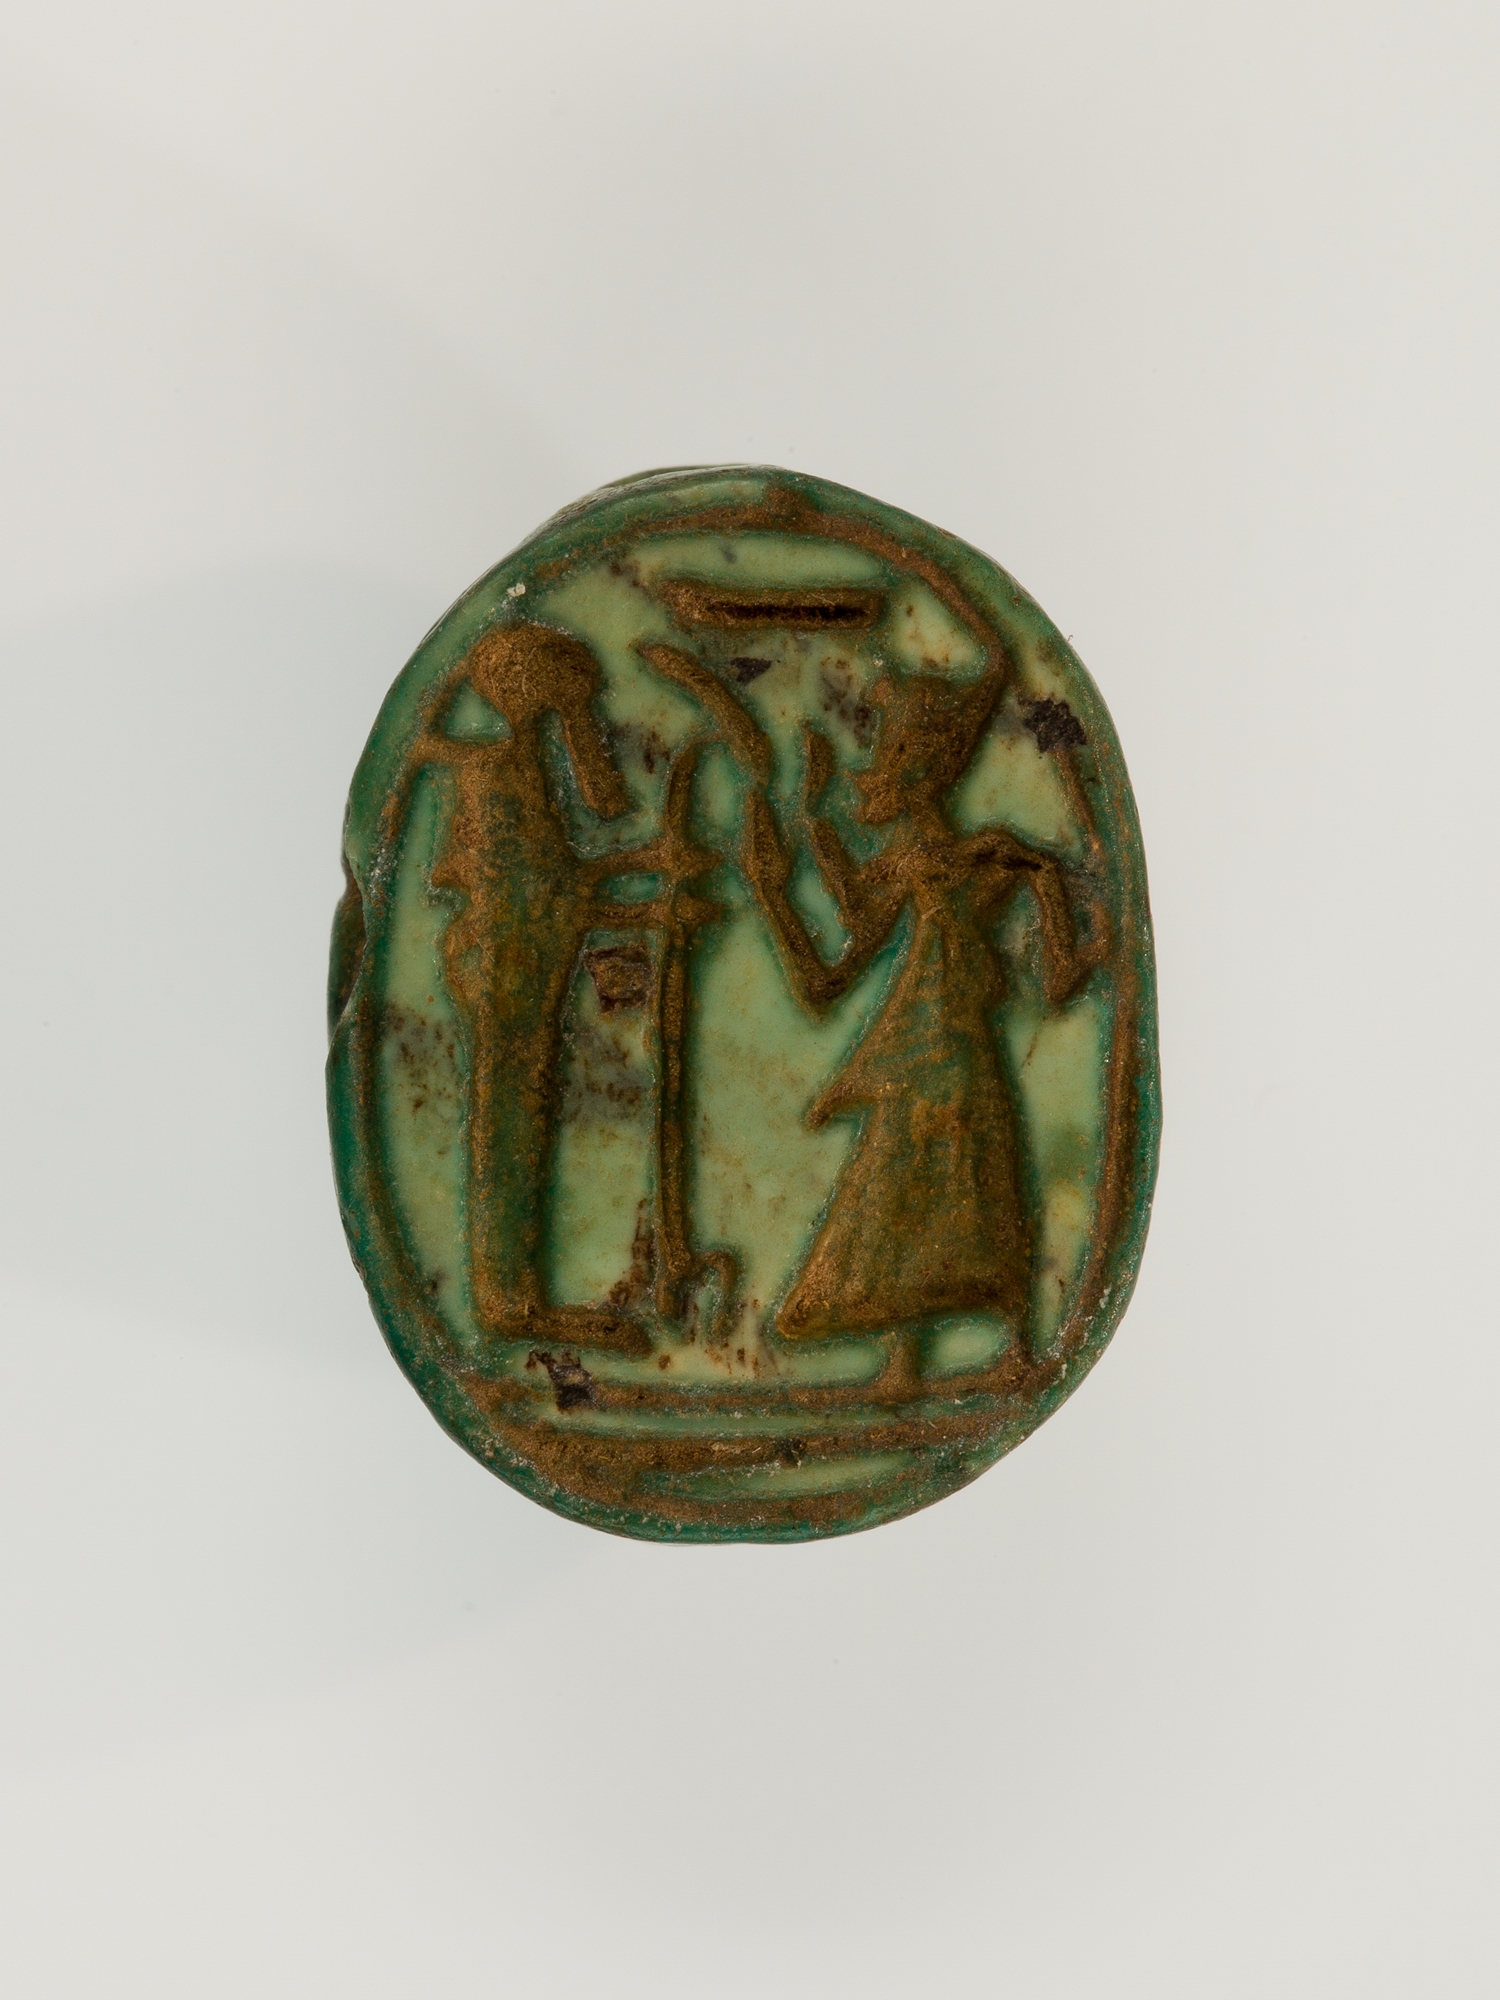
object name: scarab, ptah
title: Scarab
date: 1295-1070 BCE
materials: stone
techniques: glazing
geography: egypt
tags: scarabs